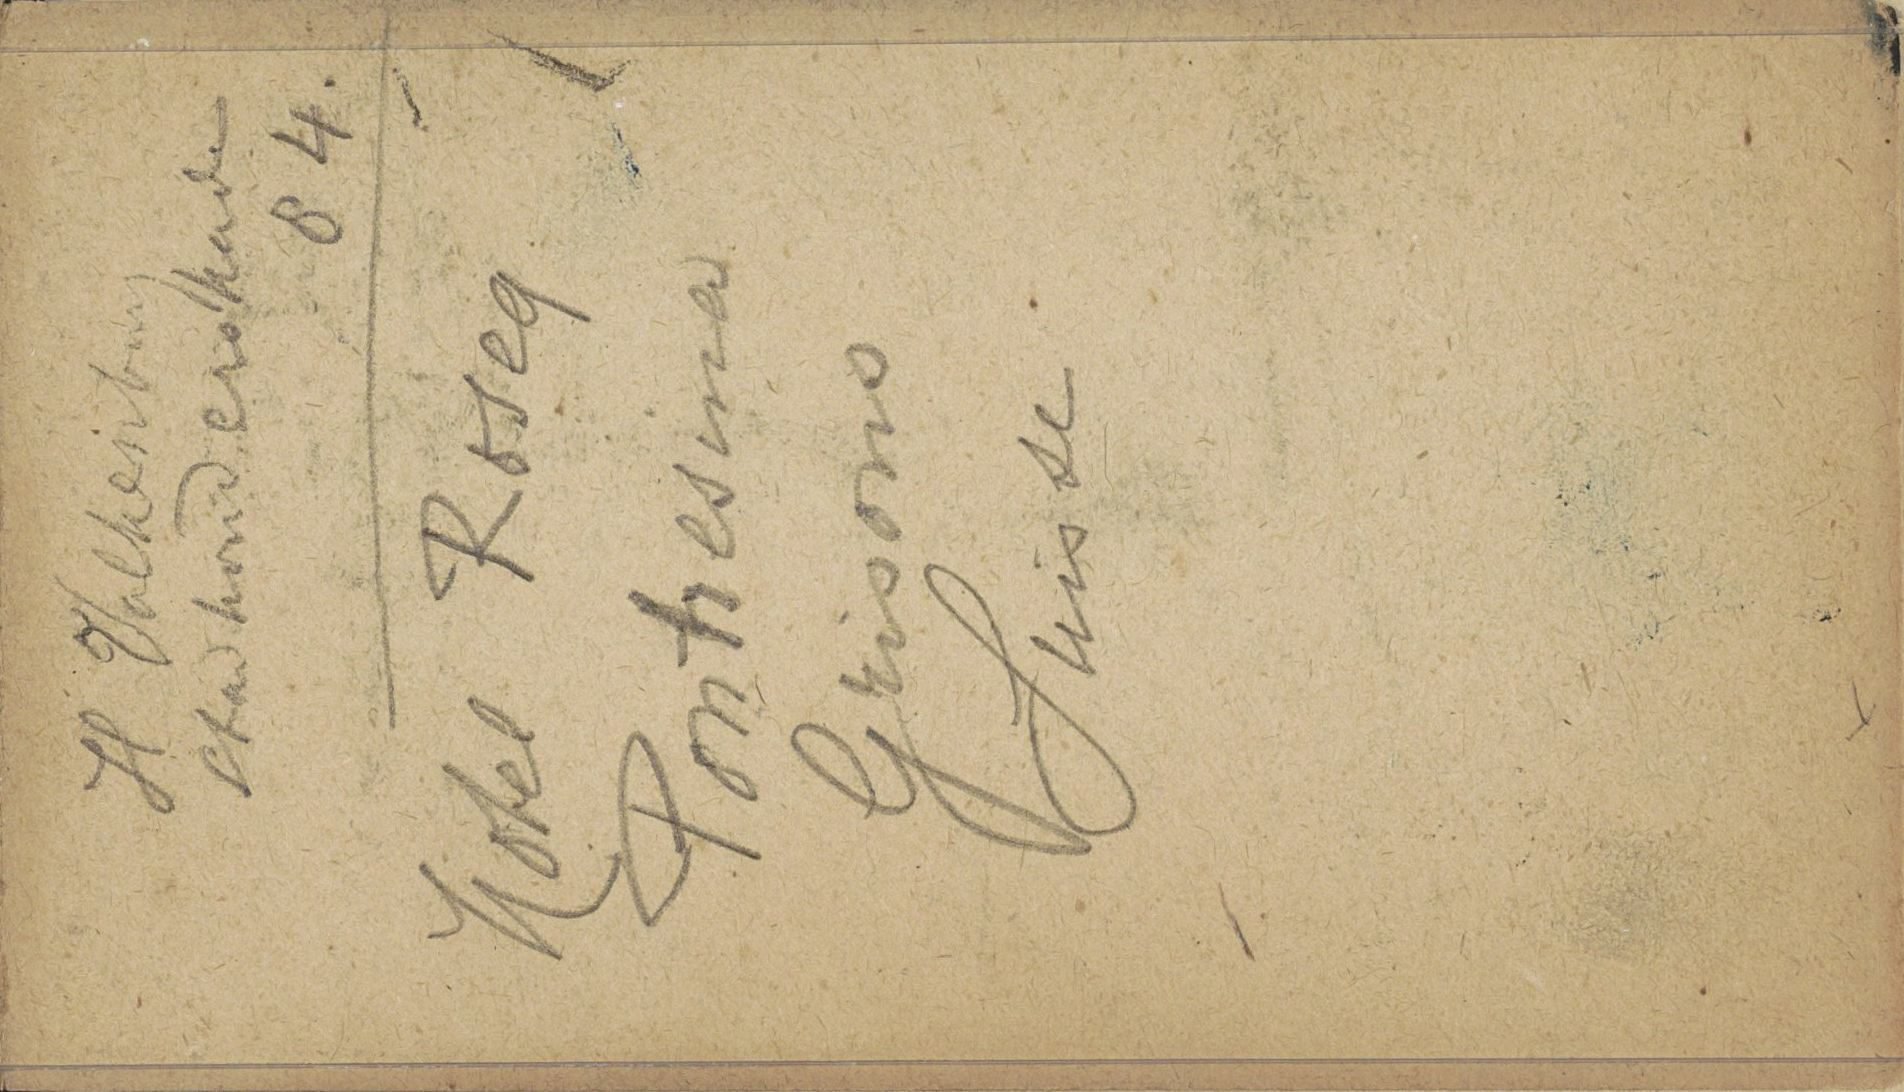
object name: sketchbook leaf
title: Notities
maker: anton mauve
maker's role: draughtsman, painter, print maker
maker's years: 1838-1888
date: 1876-1879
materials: paper, pencil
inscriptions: annotation: ‘H Valkenburg/ stadshouderskade 84./ Hotel Roseq/ Ponthesina/ Grisono/ Suisse’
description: Blad 1 recto uit een schetsboek met 33 bladen.